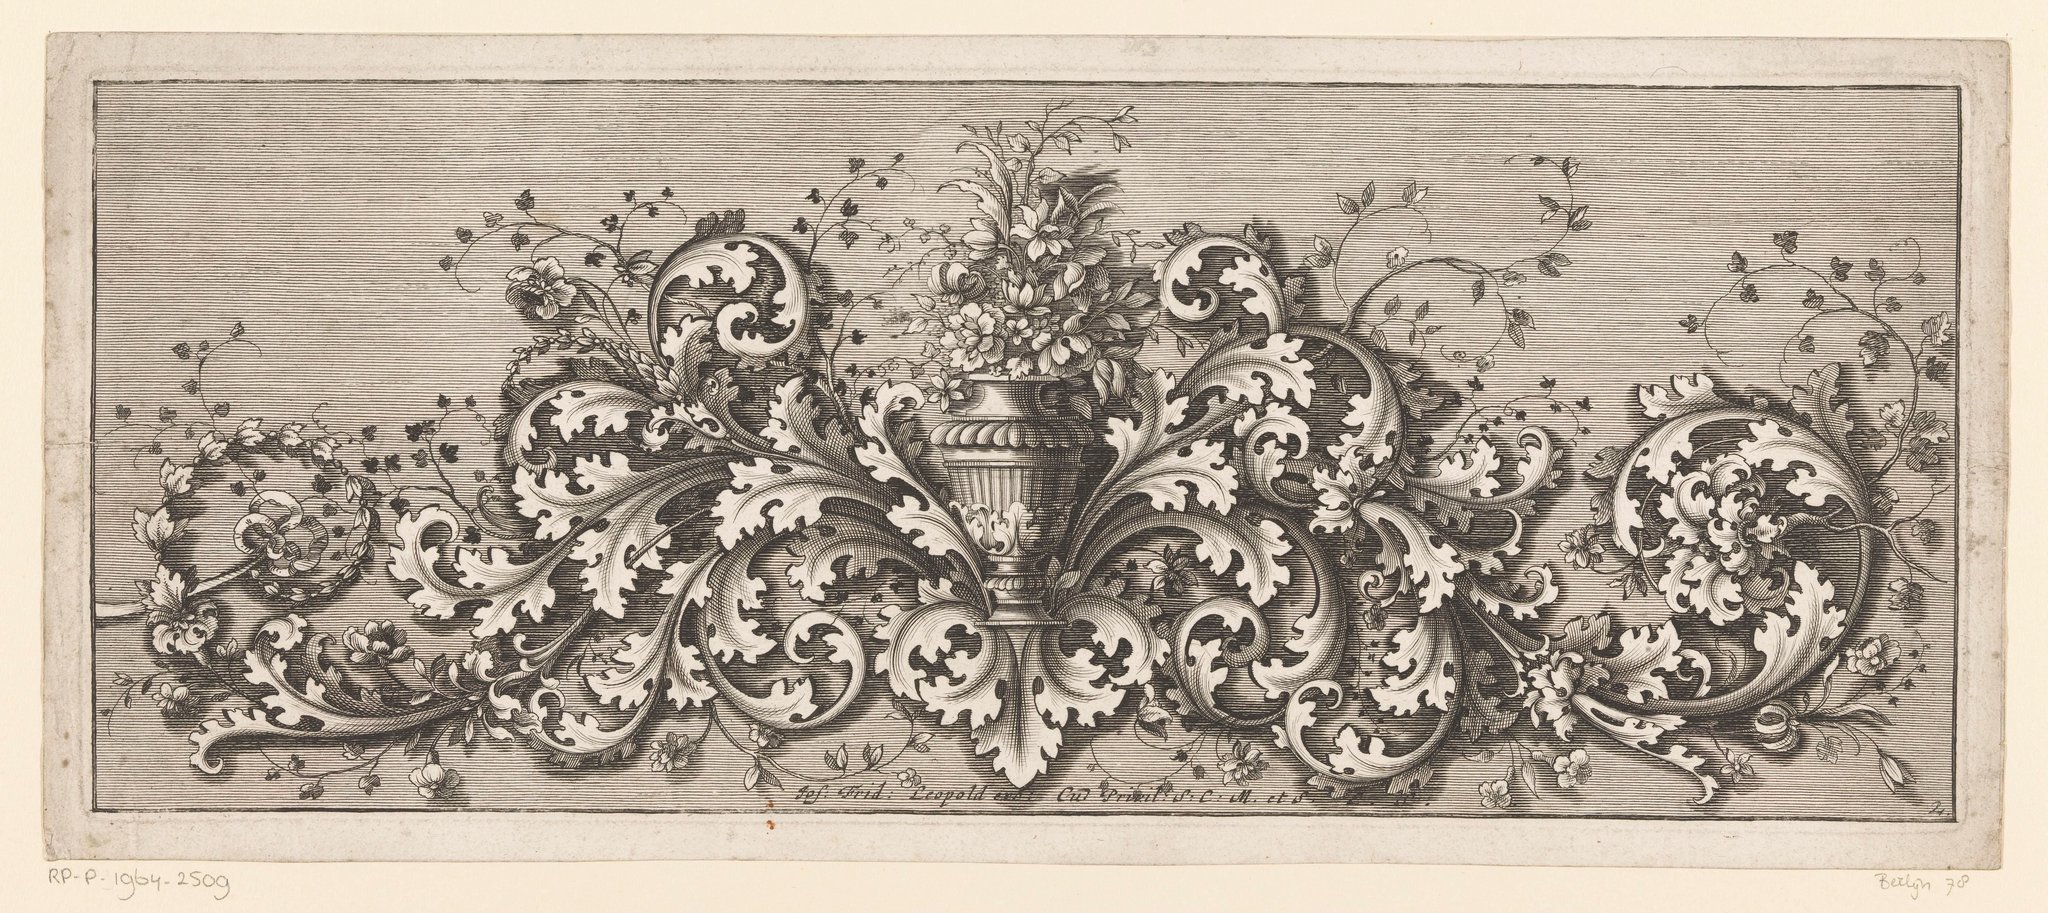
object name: print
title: Acanthusranken met vaas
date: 1698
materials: paper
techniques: engraving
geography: augsburg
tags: acanthus ~ ornament, vase ~ ornament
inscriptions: collector's mark: Lugt 2228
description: Acanthusranken met in het midden een vaas met bloemen.